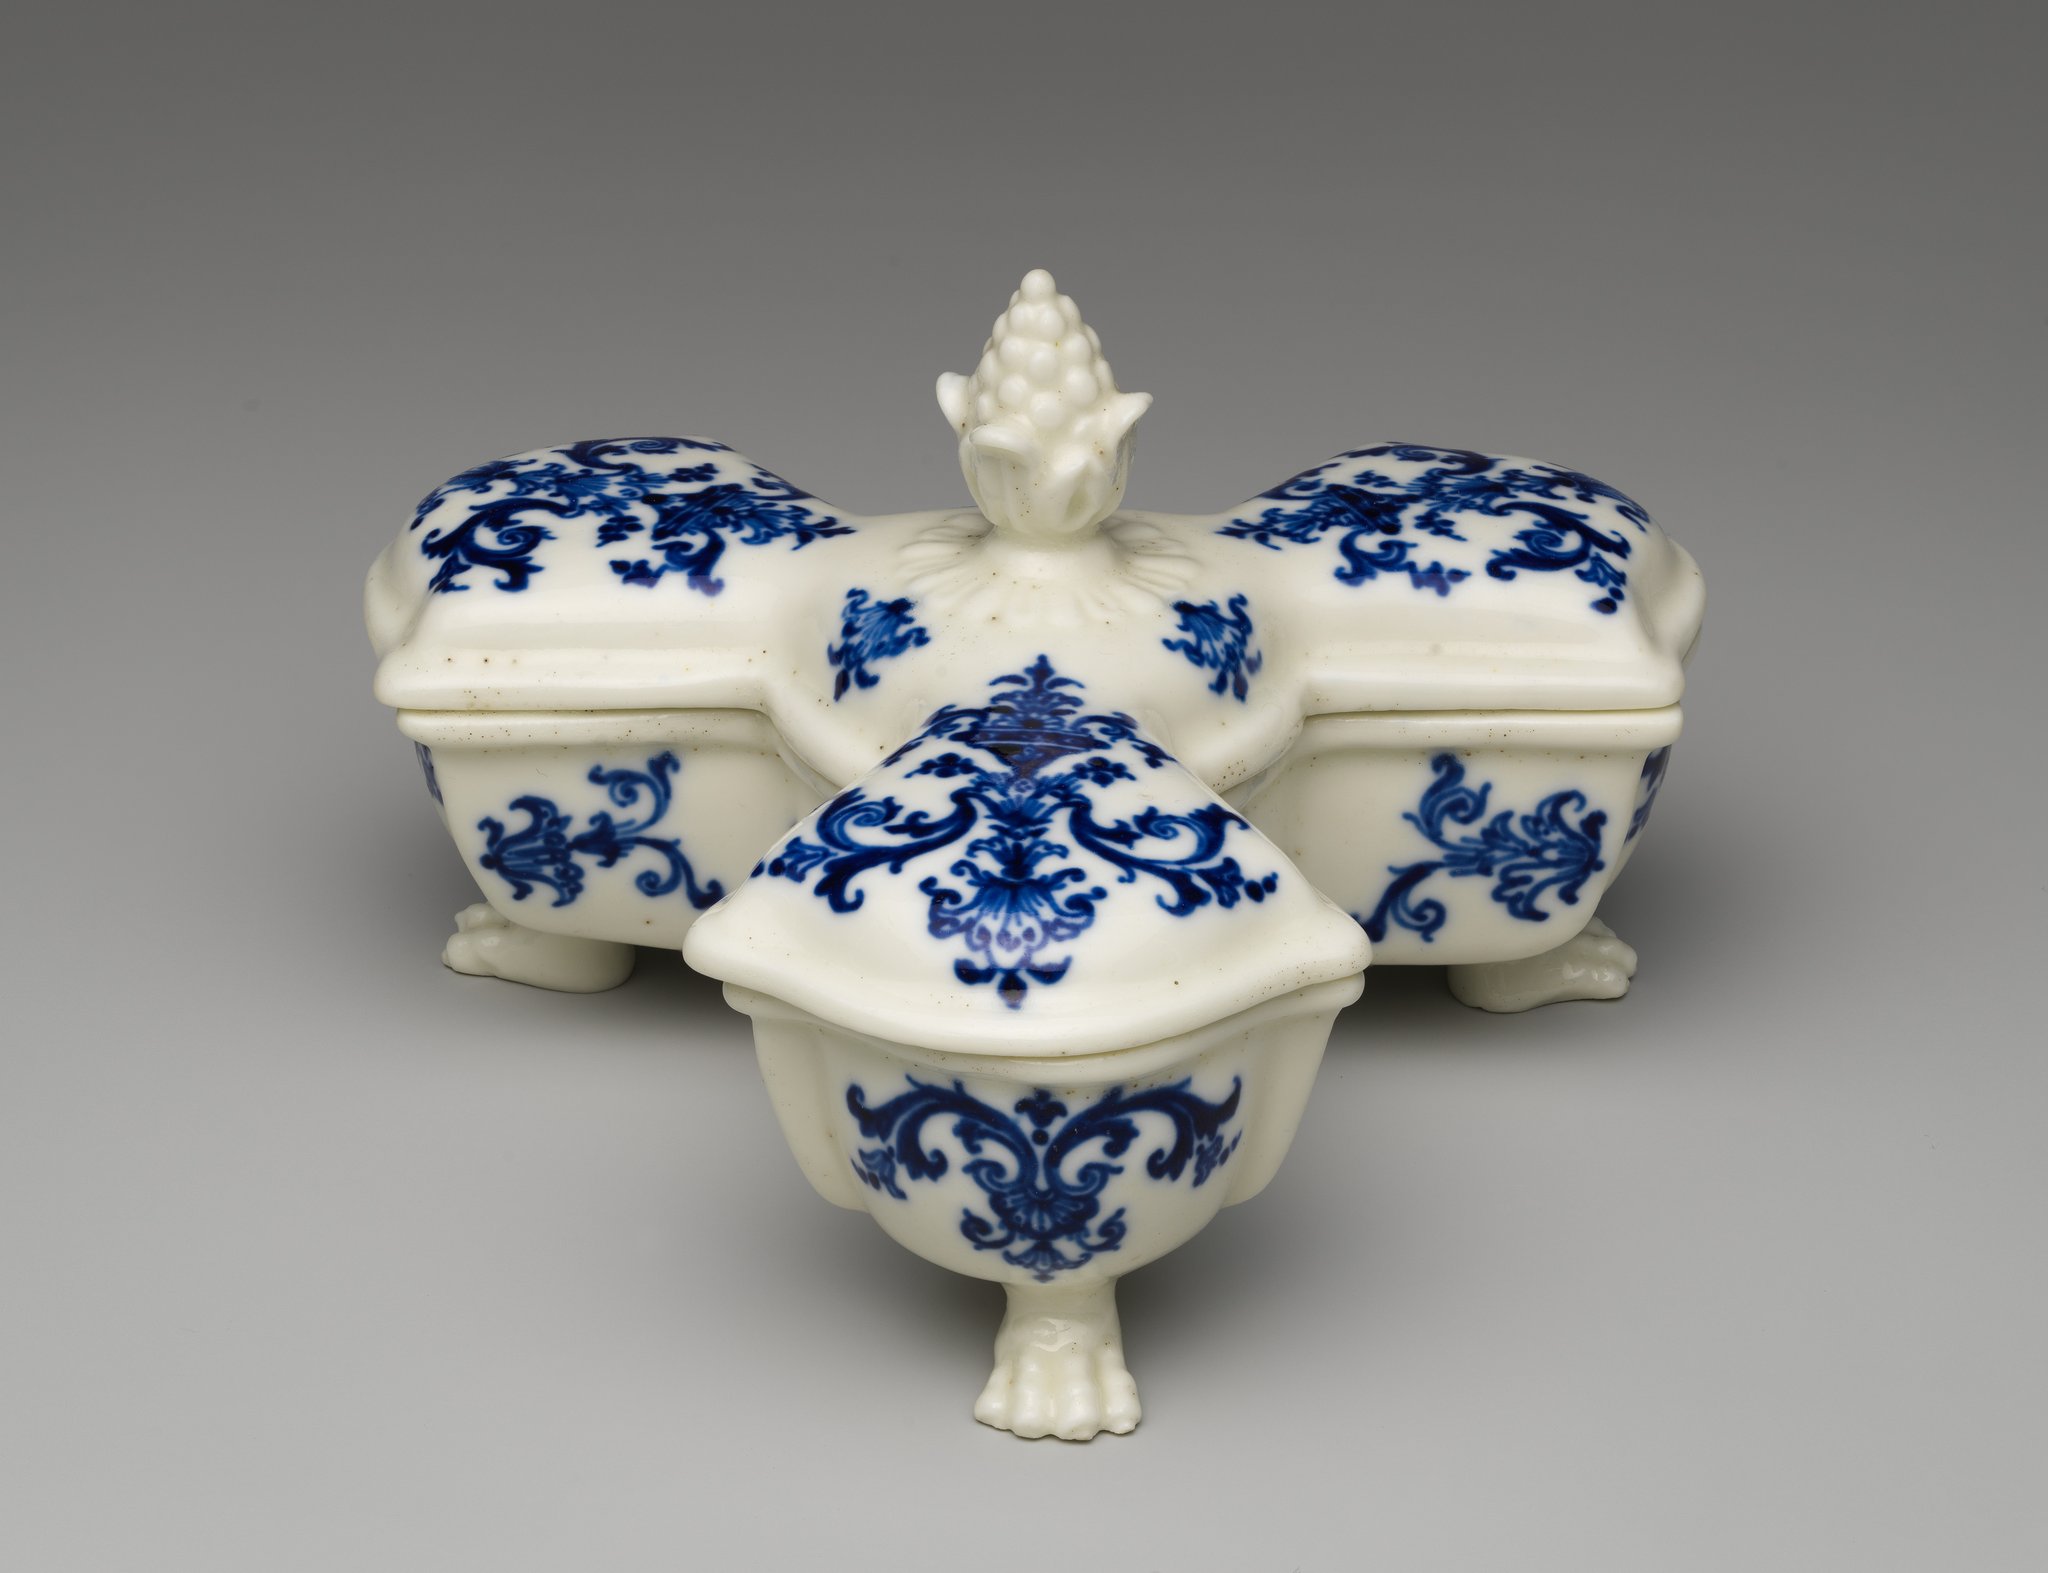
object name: spice box with cover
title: Spice box with cover (Poivrière)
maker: saint-cloud factory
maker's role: factory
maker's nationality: french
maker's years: 1693-1766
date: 1710-1730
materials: soft paste porcelain